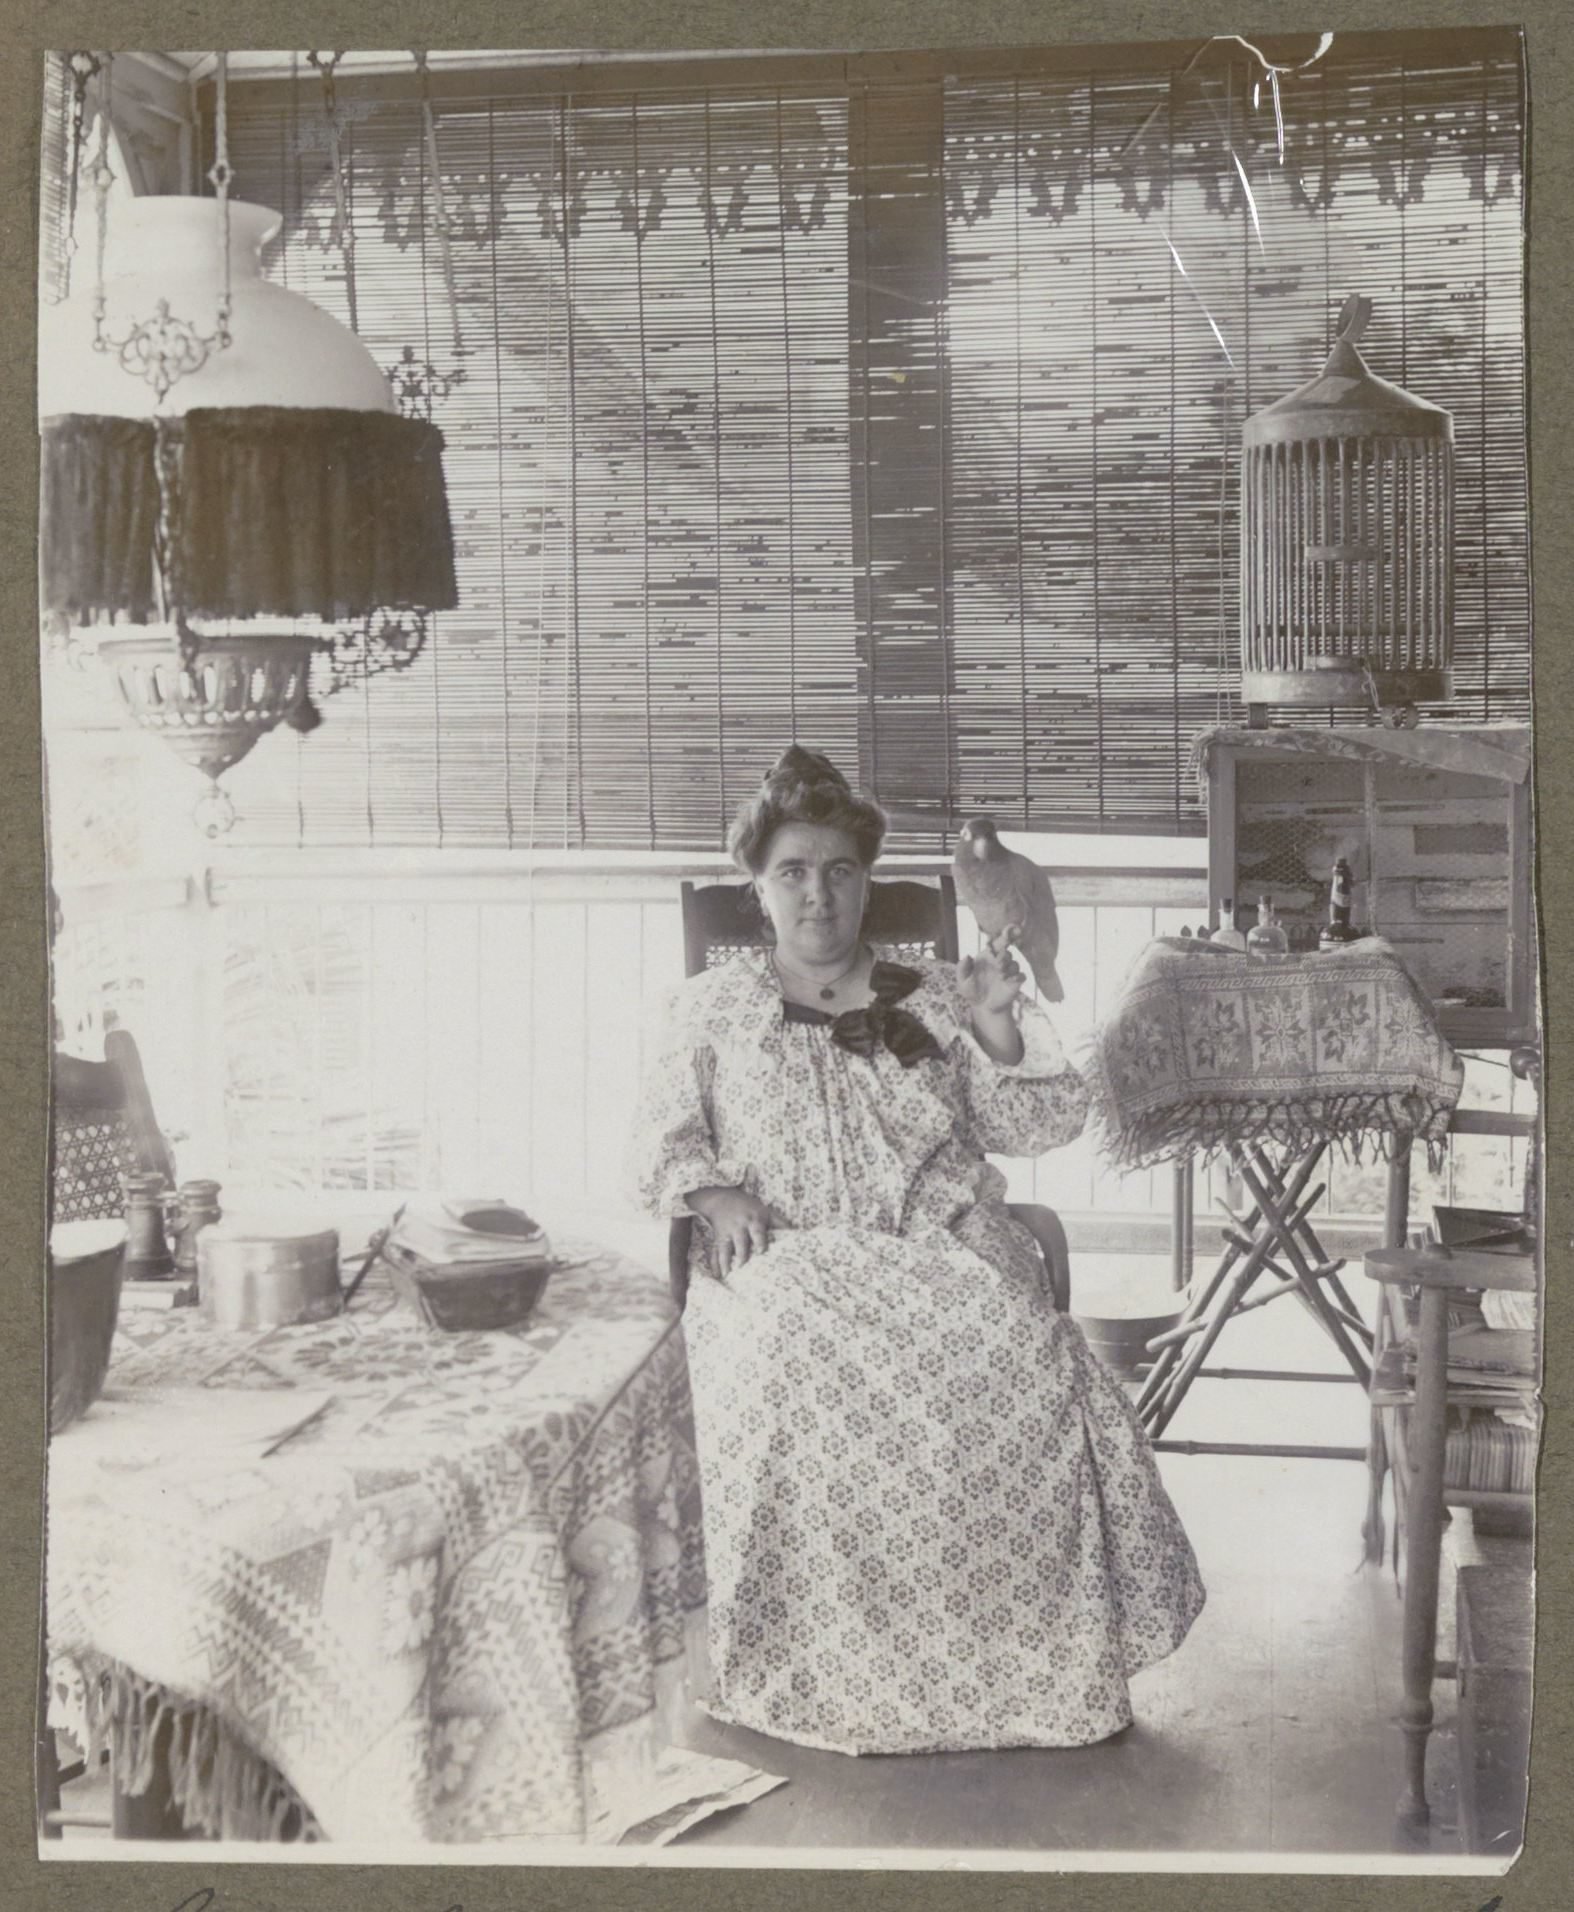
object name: photograph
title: Zittende vrouw met vogel op de hand, mogelijk in Suriname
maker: Anonymous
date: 1917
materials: photographic support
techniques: gelatin silver print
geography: suriname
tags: adult woman, domestic birds (inside the house), living-room, parlour, sitting-room, suriname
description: Onderdeel van fotoalbum van een onbekende Nederlandse familie met opnames van Suriname, Europa en Nederlands-Indië.